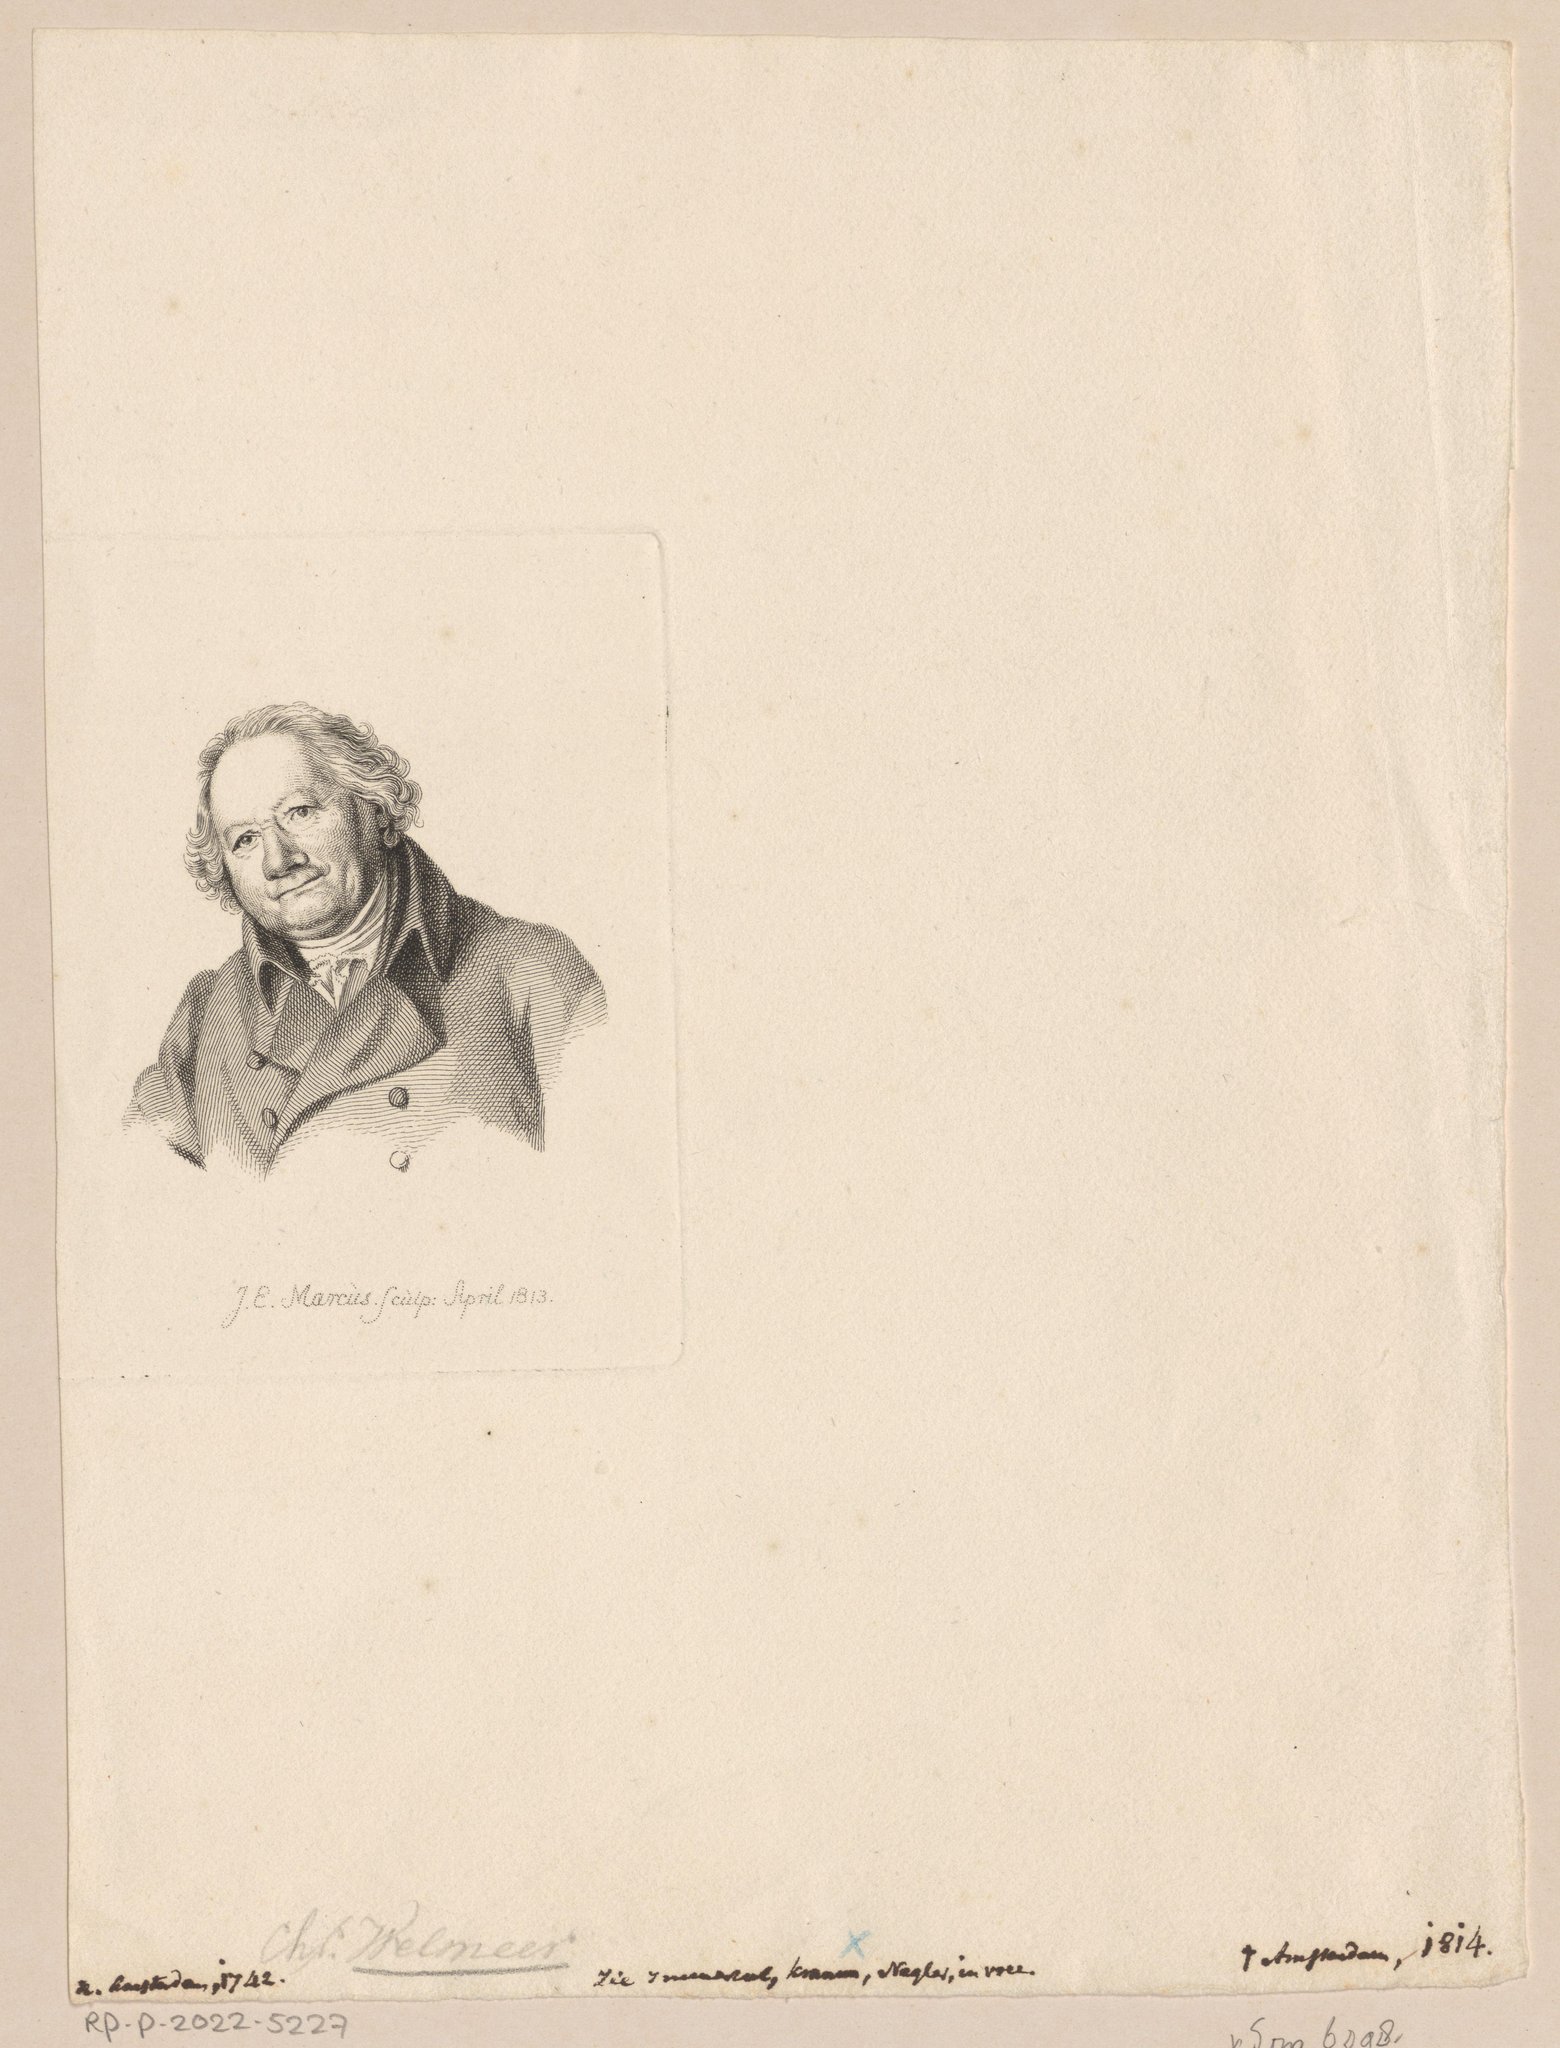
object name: print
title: Studie-prentwerk / Etudes gravées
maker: jacob ernst marcus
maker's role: draughtsman, print maker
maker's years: 1774-1826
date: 1804-1813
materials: paper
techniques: etching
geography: amsterdam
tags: amsterdam, draughtsman, sculptor, christiaan welmeer, historical persons, portrait, self-portrait of artist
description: Serie voor het eerst uitgegeven door Jacob Ernst Marcus onder de titel Studiebeelden en Fragmenten. Amsterdam: ca.1816. Later heruitgegeven als: Studie-prentwerk/ Etudes gravées.